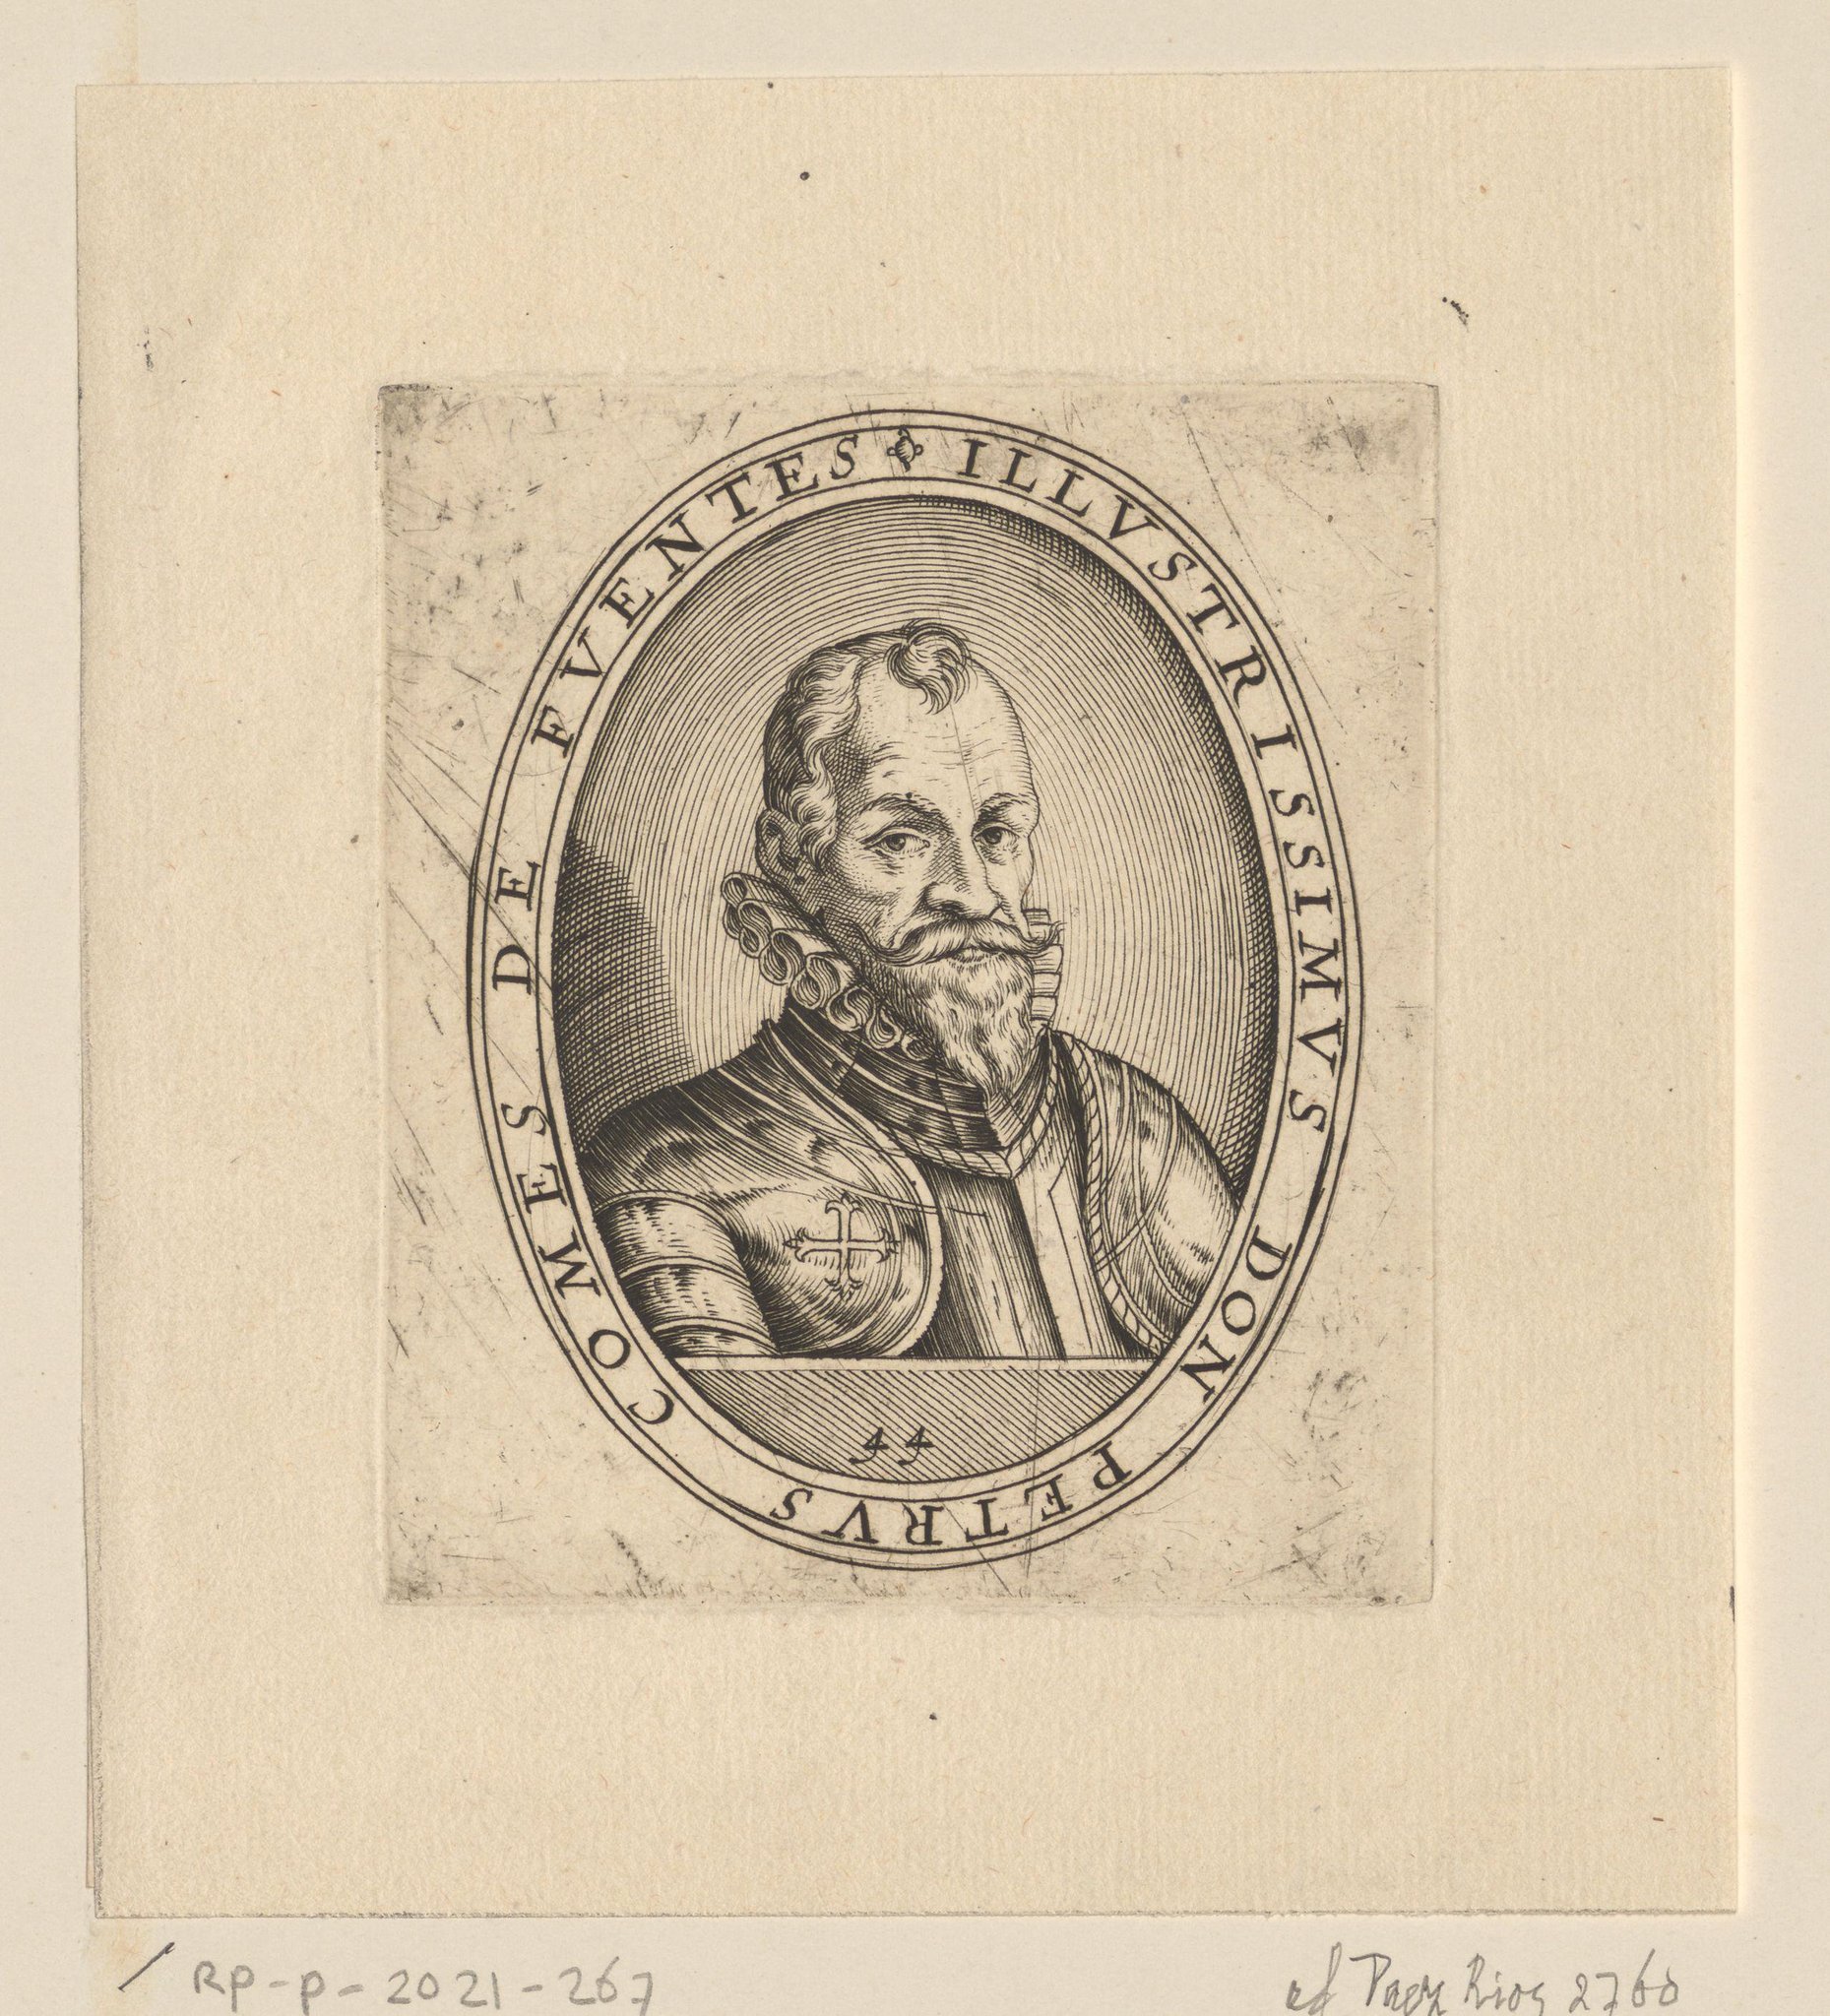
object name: print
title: Portret van Pedro Enríquez de Acevedo, graaf van Fuentes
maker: Anonymous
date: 1590-1650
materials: paper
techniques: engraving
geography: low countries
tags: pedro enríquez de acevedo (count of fuentes), commander-in-chief, general, marshal, armour, historical persons